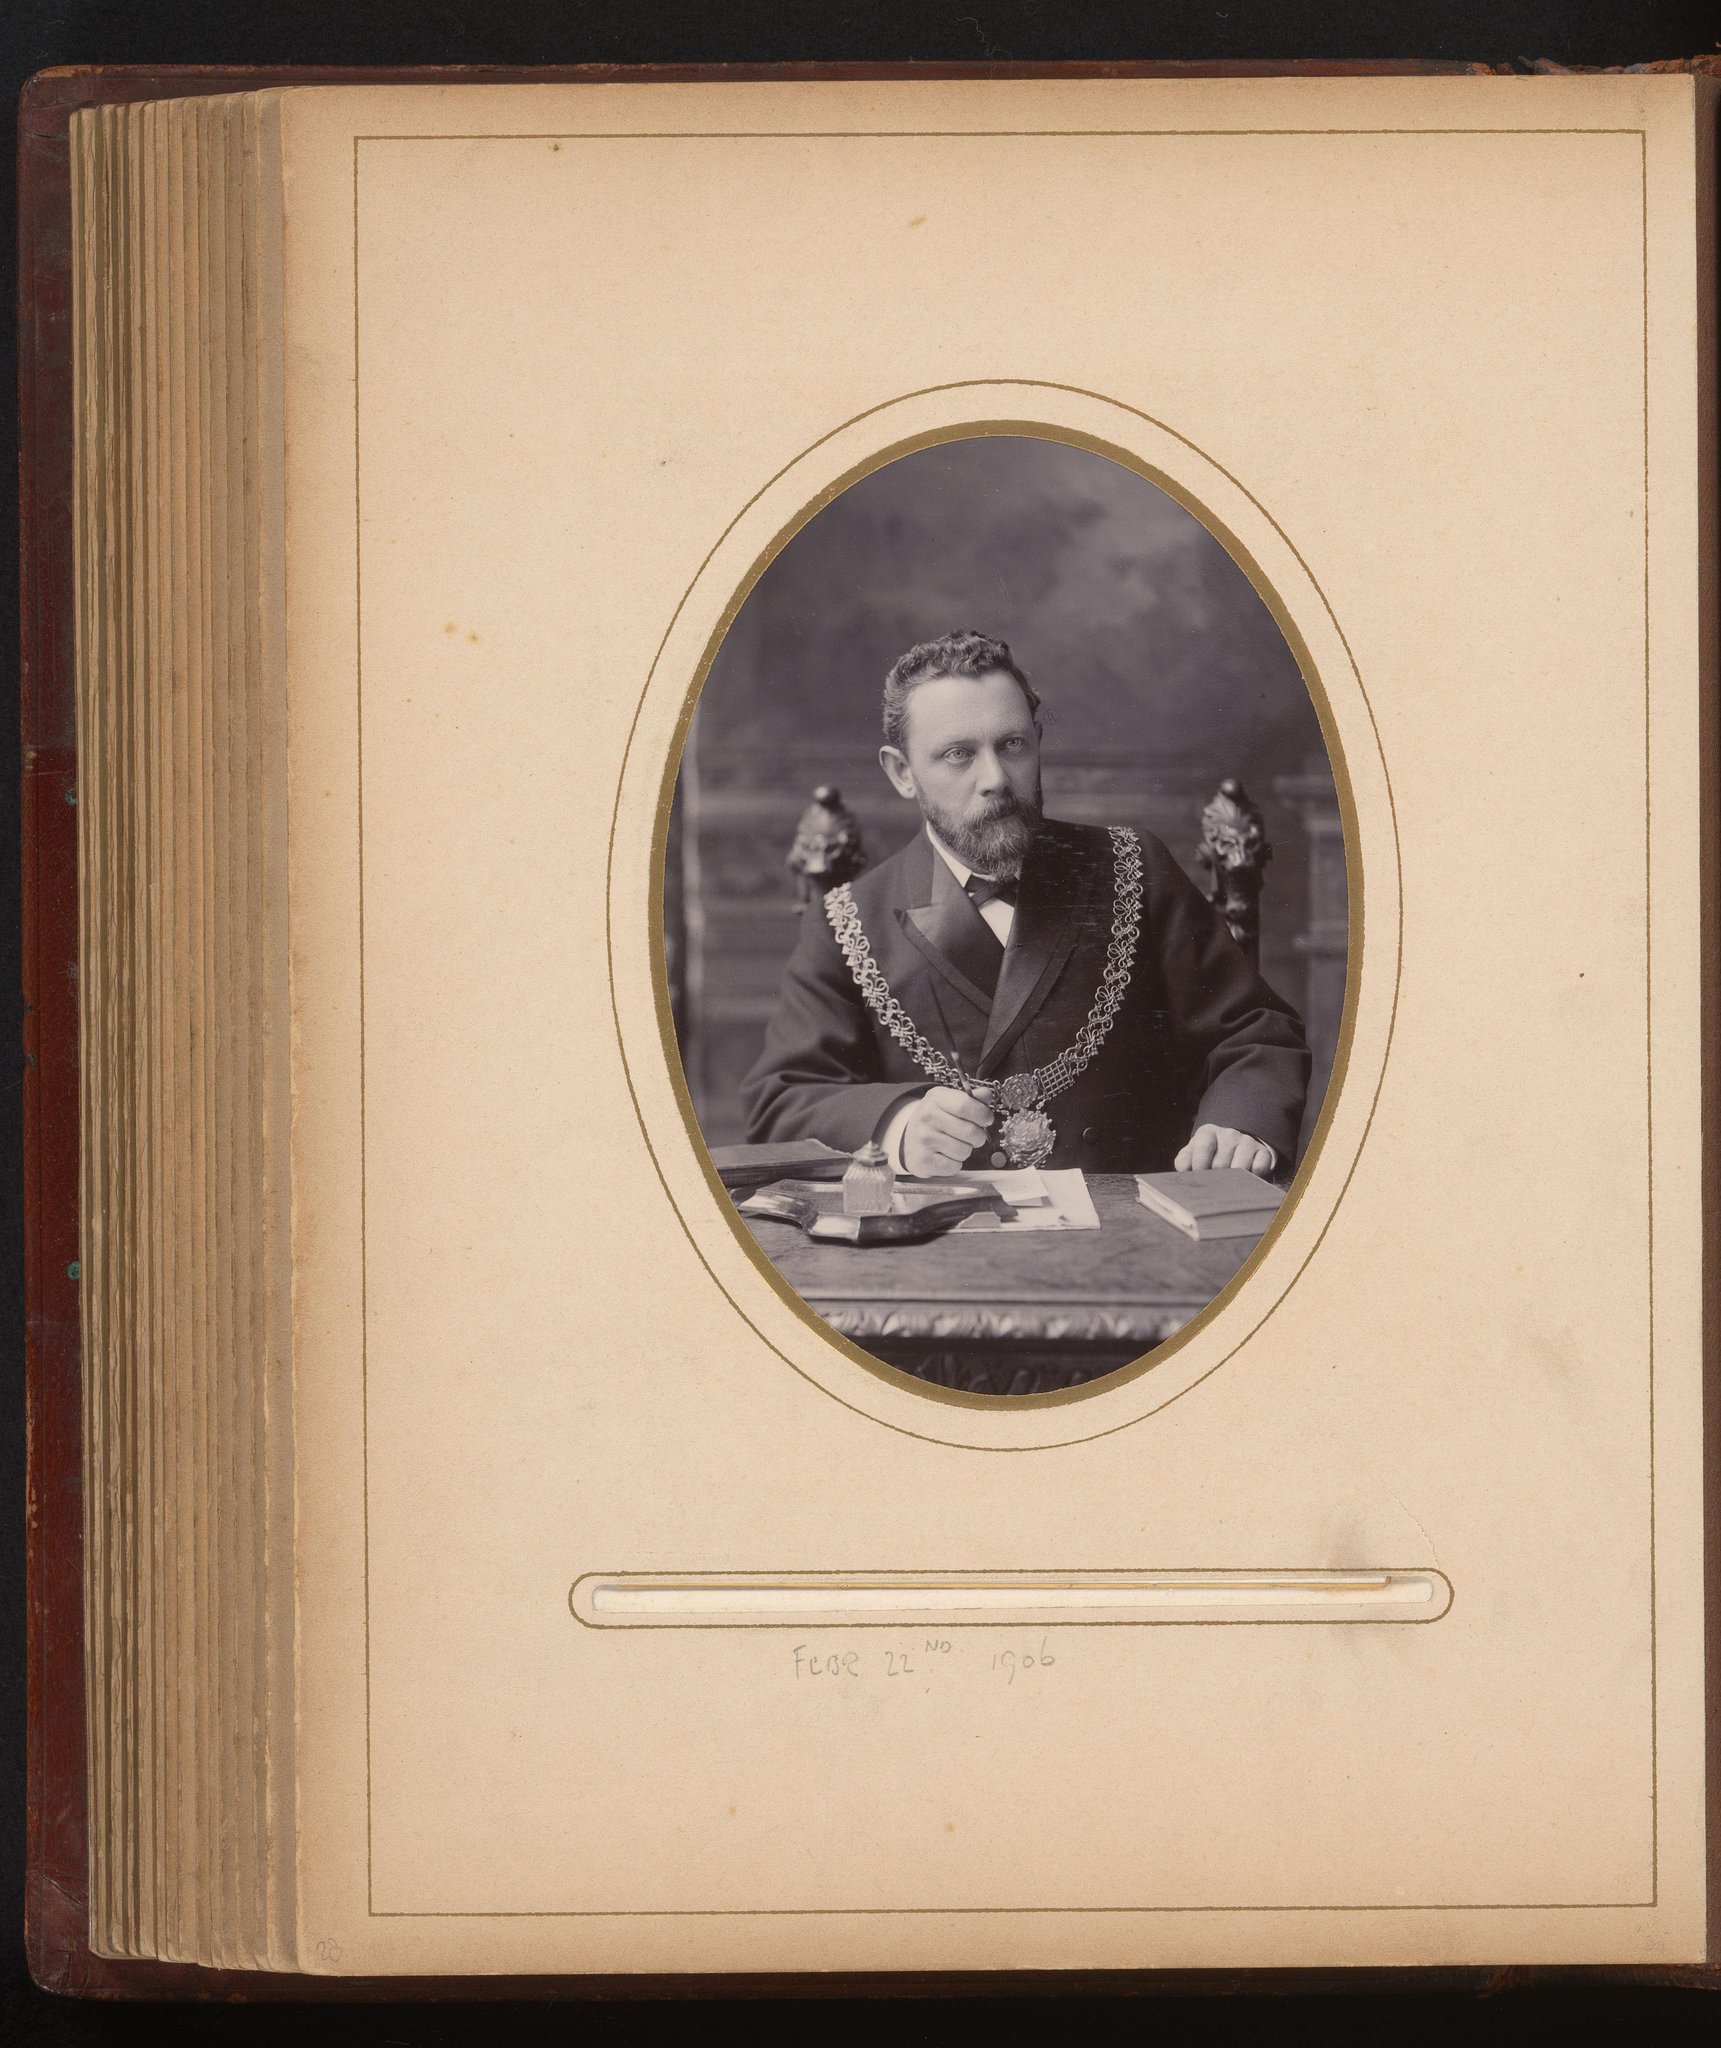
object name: album leaf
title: Portret van een man, vermoedelik een burgemeester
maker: w.w. winter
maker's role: fotograaf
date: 1902-1906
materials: cardboard, photographic support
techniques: daylight paper print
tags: other non-personal regalia, e.g. mayor chain, adult man, historical persons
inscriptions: inscription: ‘(...)/ W.W. Winter/ Art Photographer/ Derby/(...)’, annotation: ‘Derby/ [...]/ Feb 22/ Friday/ Fe 23/ 1906’